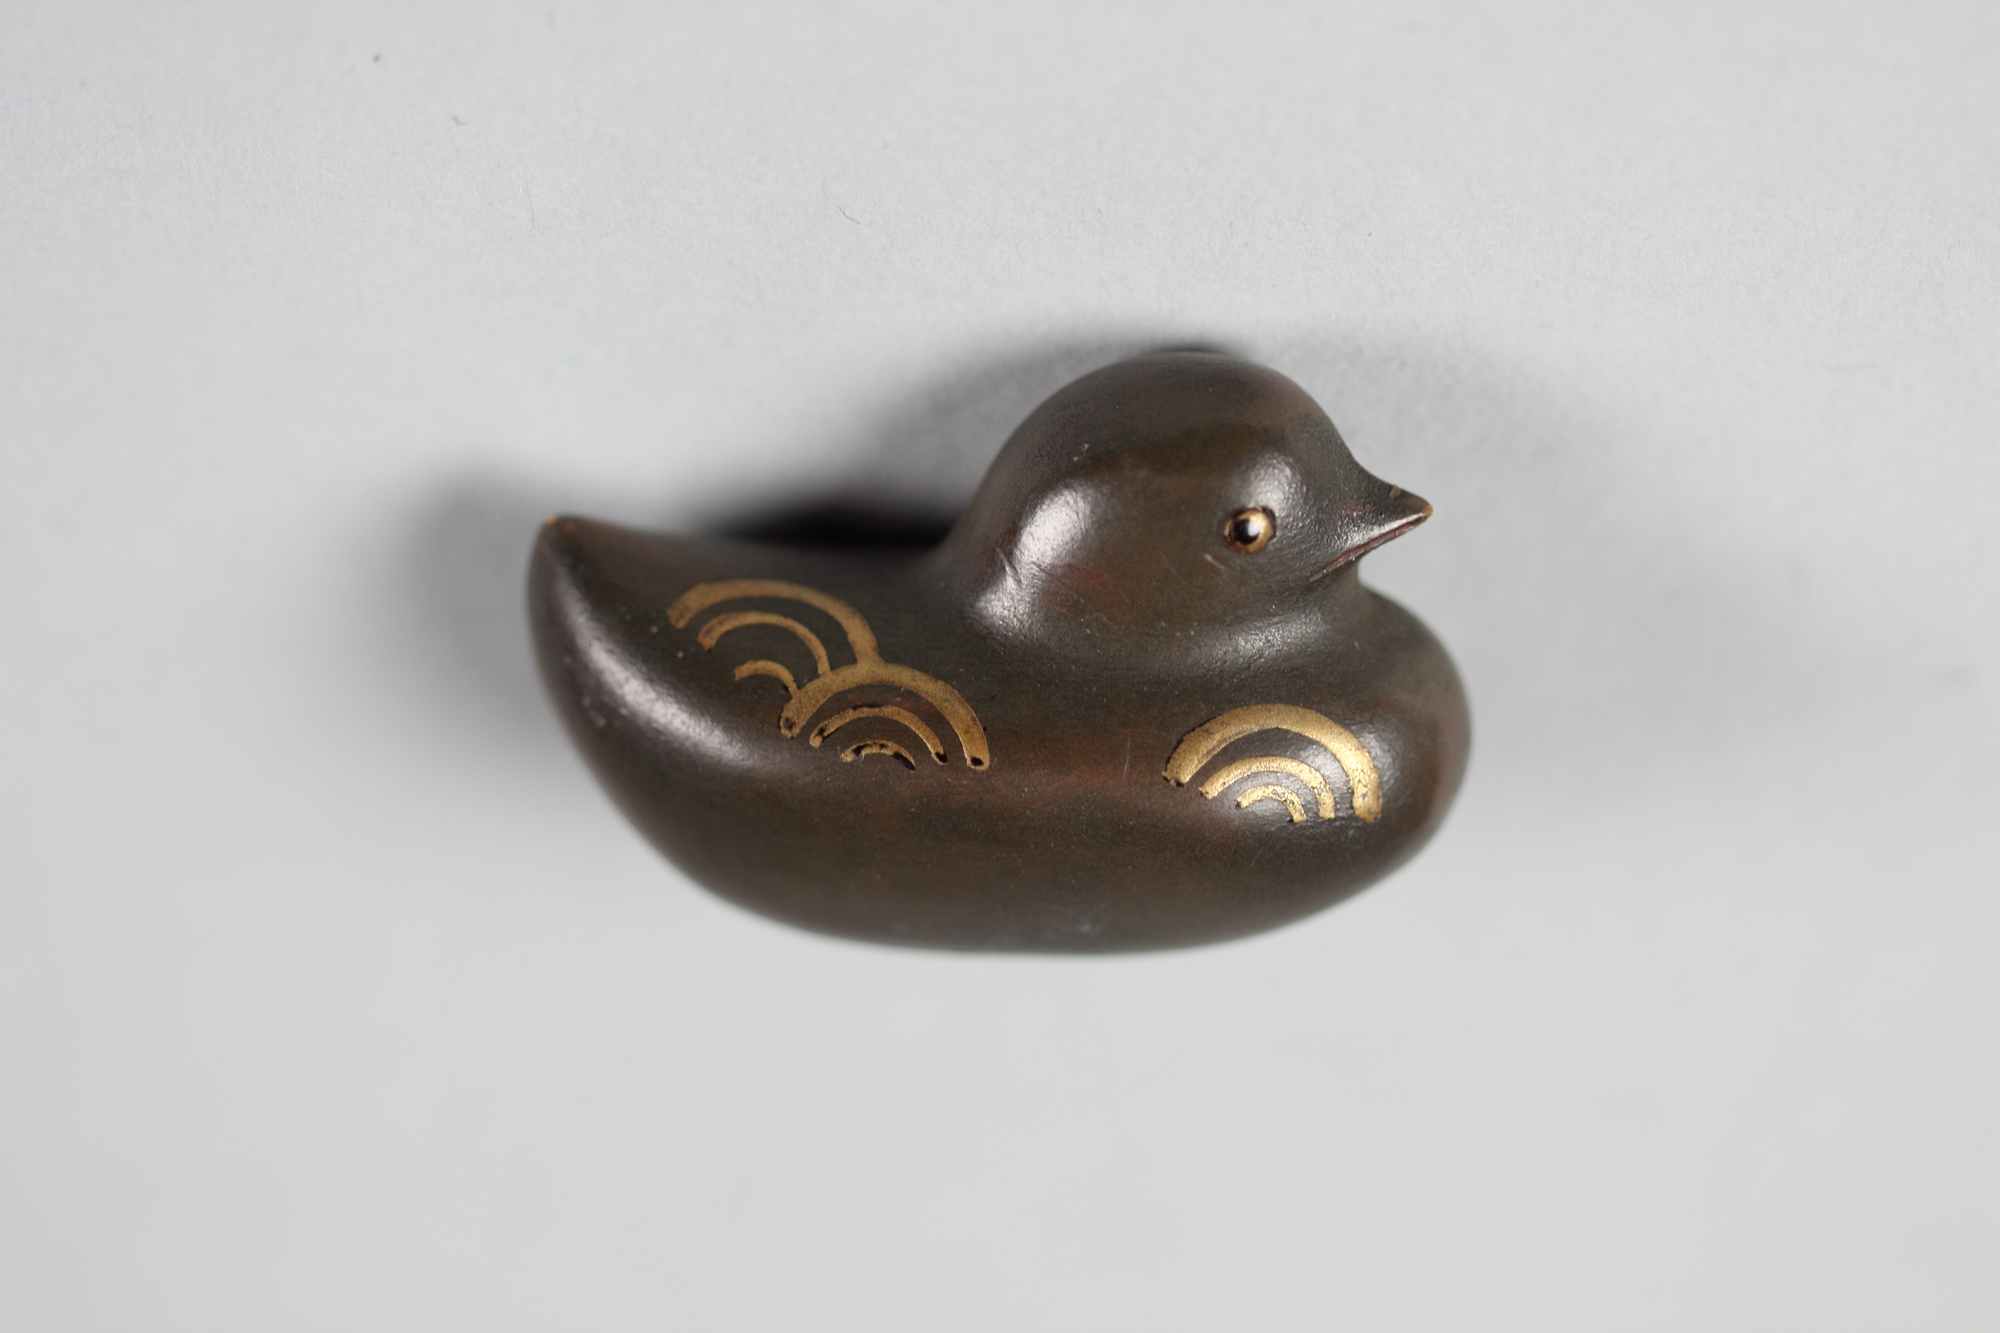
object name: netsuke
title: Netsuke of Bird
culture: japanese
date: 1801-1900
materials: gold, lacquer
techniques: painting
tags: birds